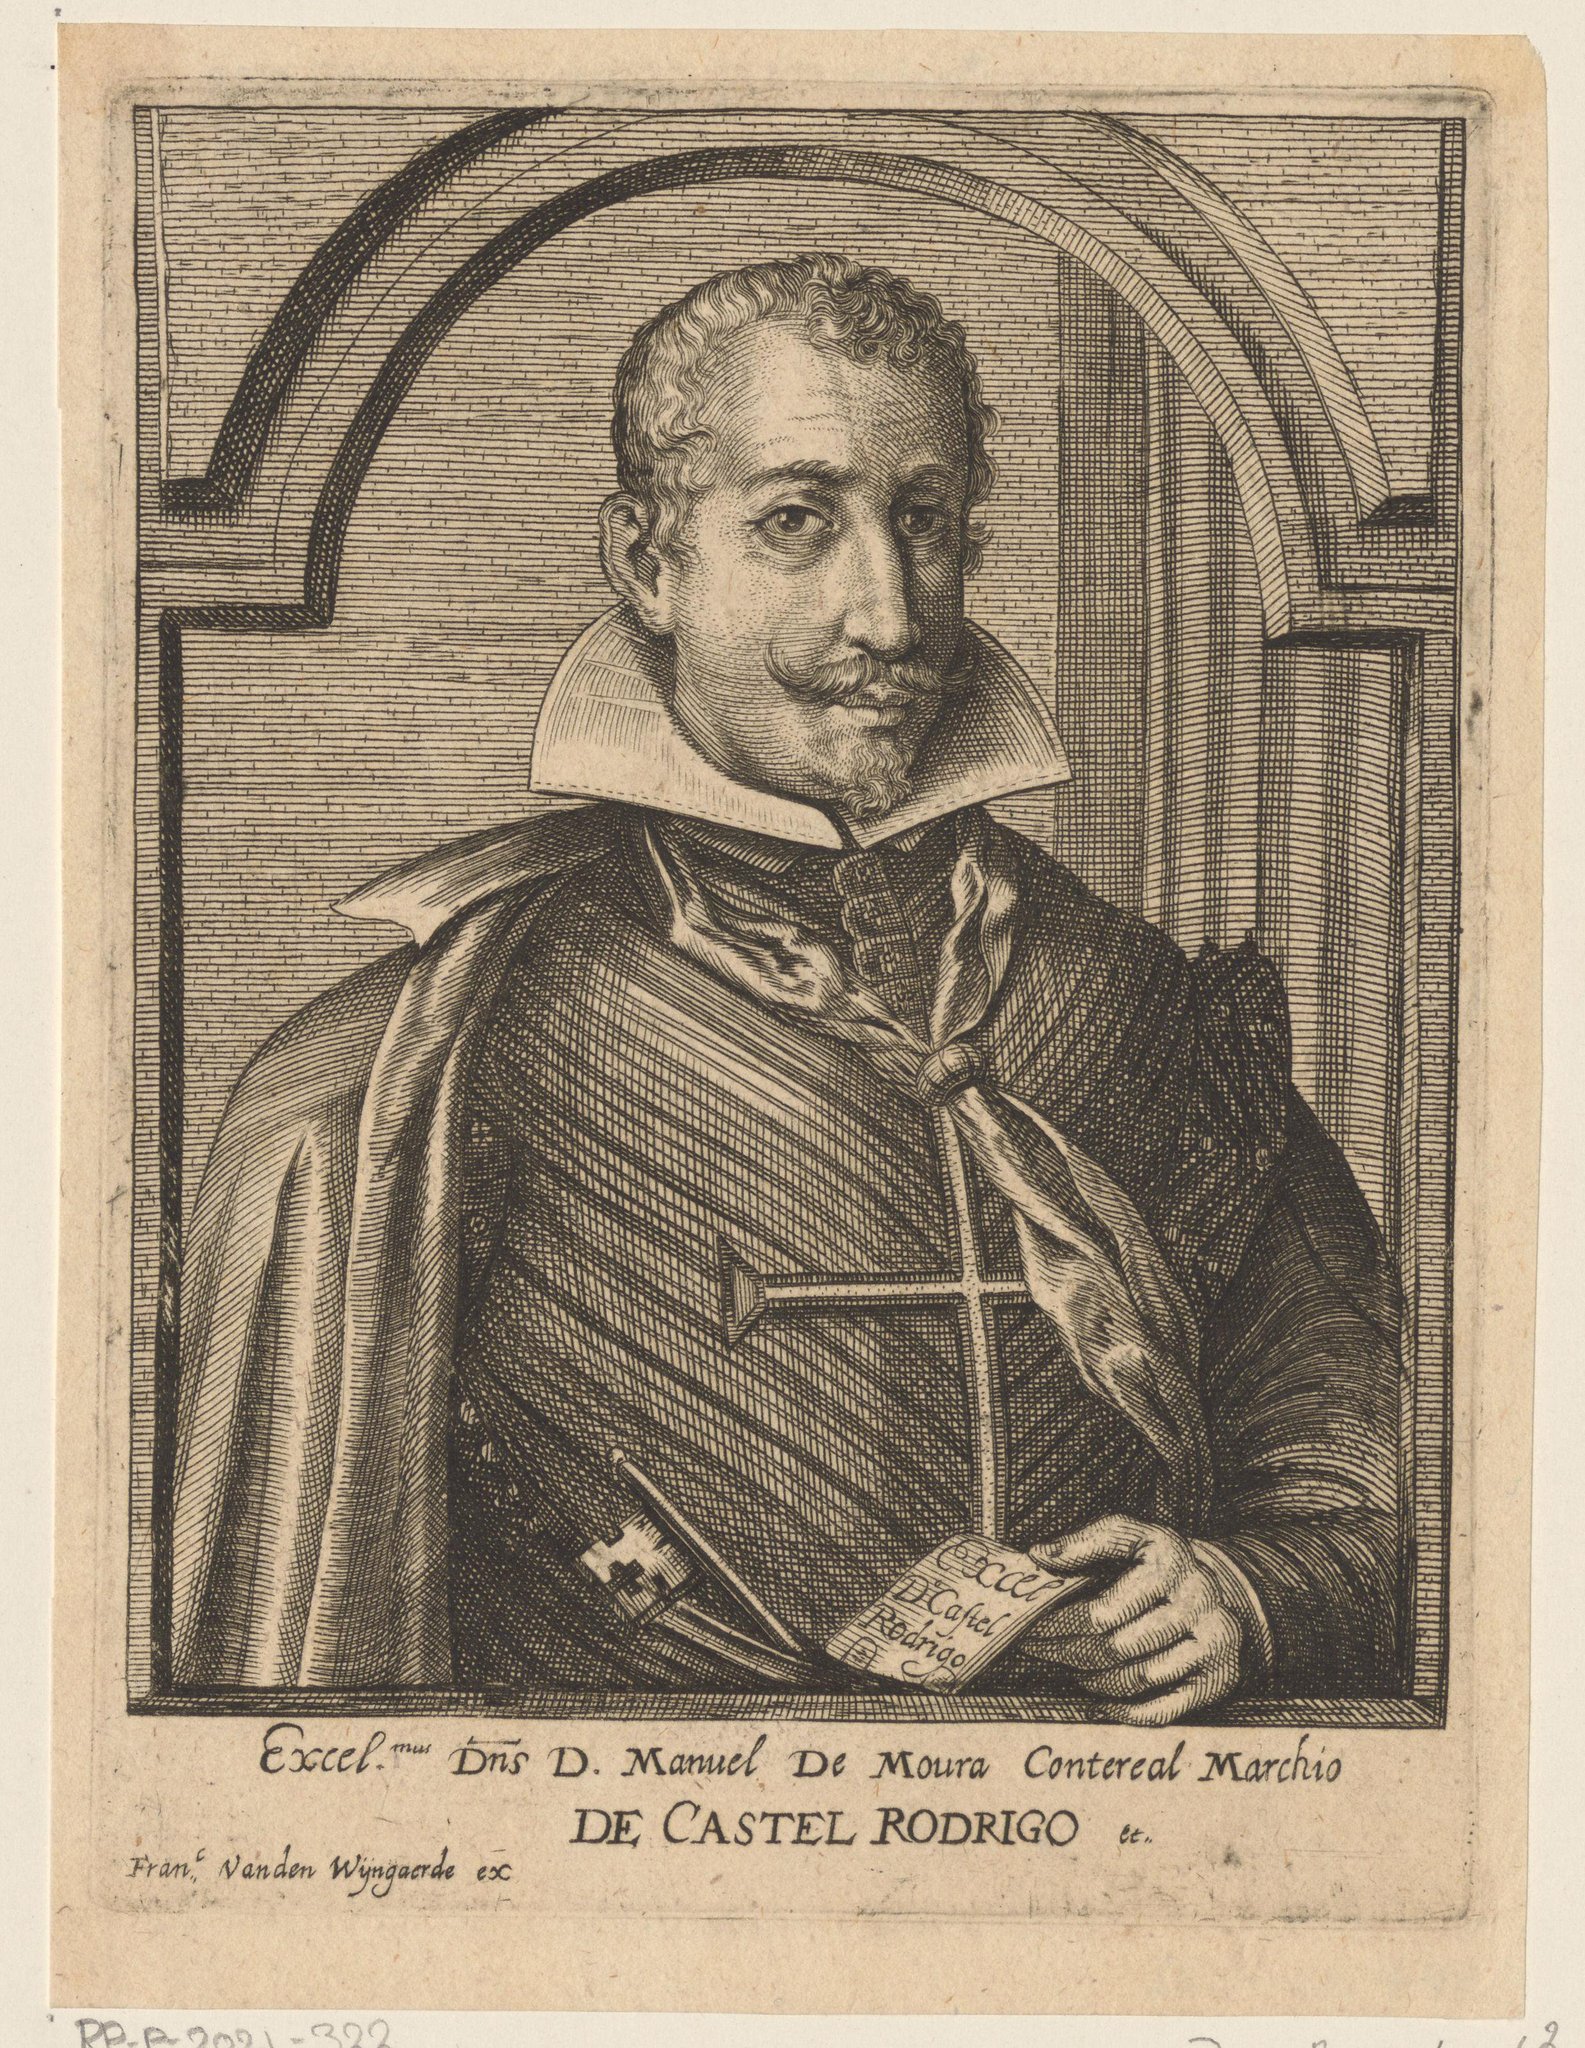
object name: print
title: Portret van Manuel de Castel Rodrigo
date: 1636-1679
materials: paper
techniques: engraving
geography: the hague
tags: historical persons